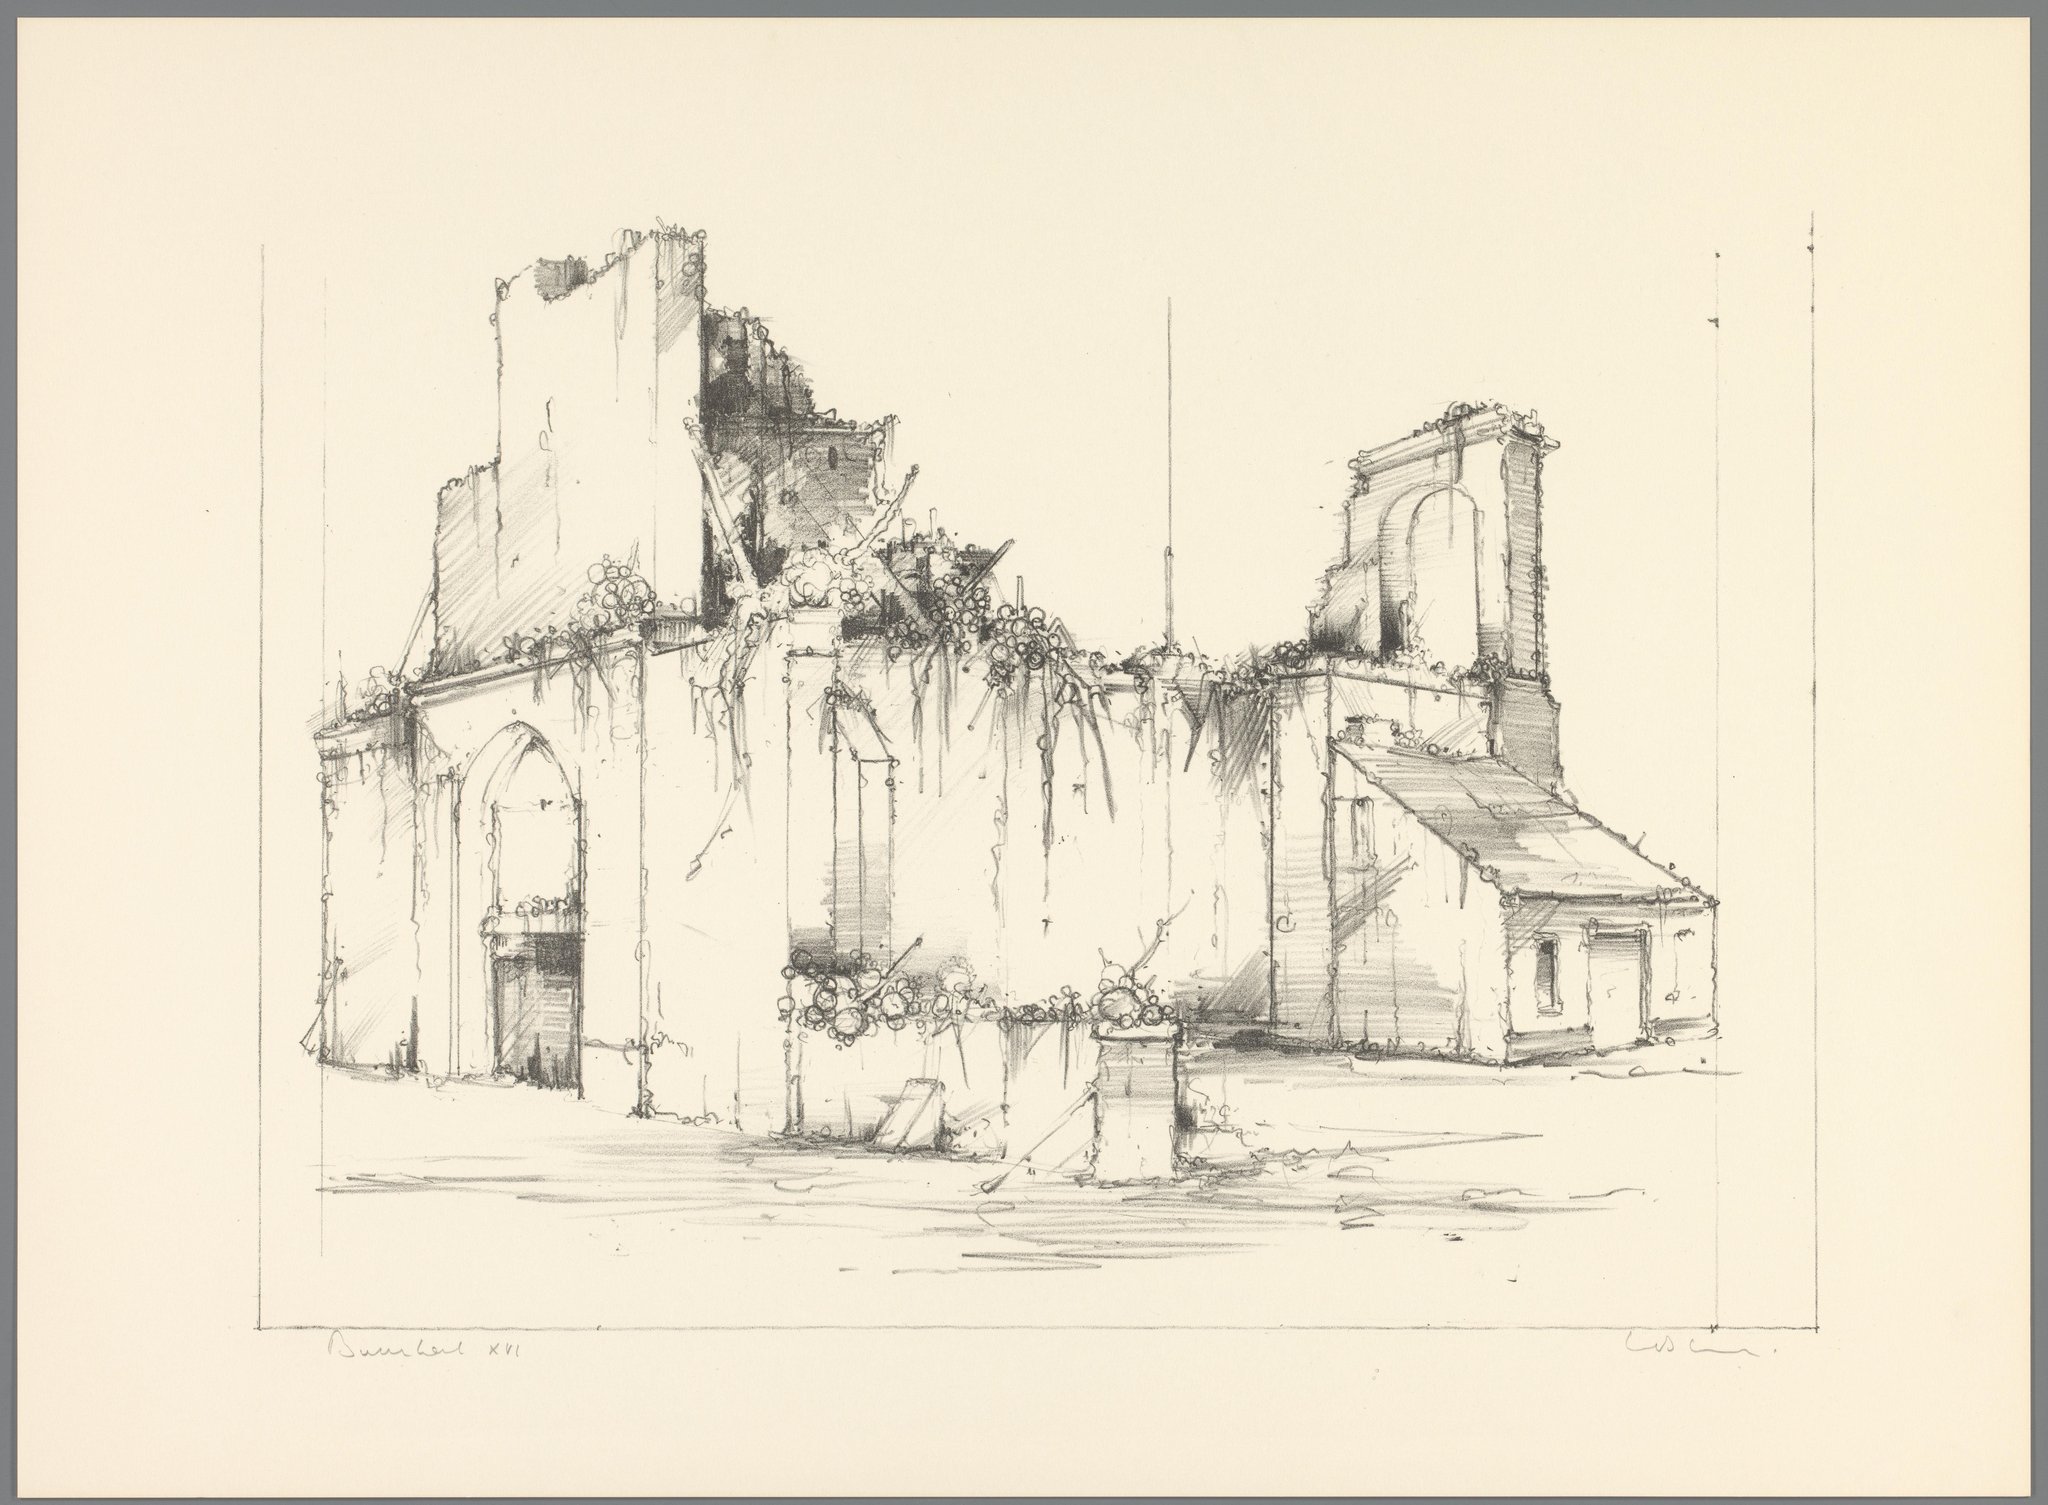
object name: print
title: Tien gezichten op Utrecht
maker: dirkje kuik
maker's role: print maker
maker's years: 1929-2008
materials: ink, paper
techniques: lithograph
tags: ruin of church, monastery, etc. - qq - small church, chapel, city-view in general; 'veduta' - ii - ideal city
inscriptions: signature: ‘WDkuik’, title: ‘Buurkerk’, edition: ‘XVI’